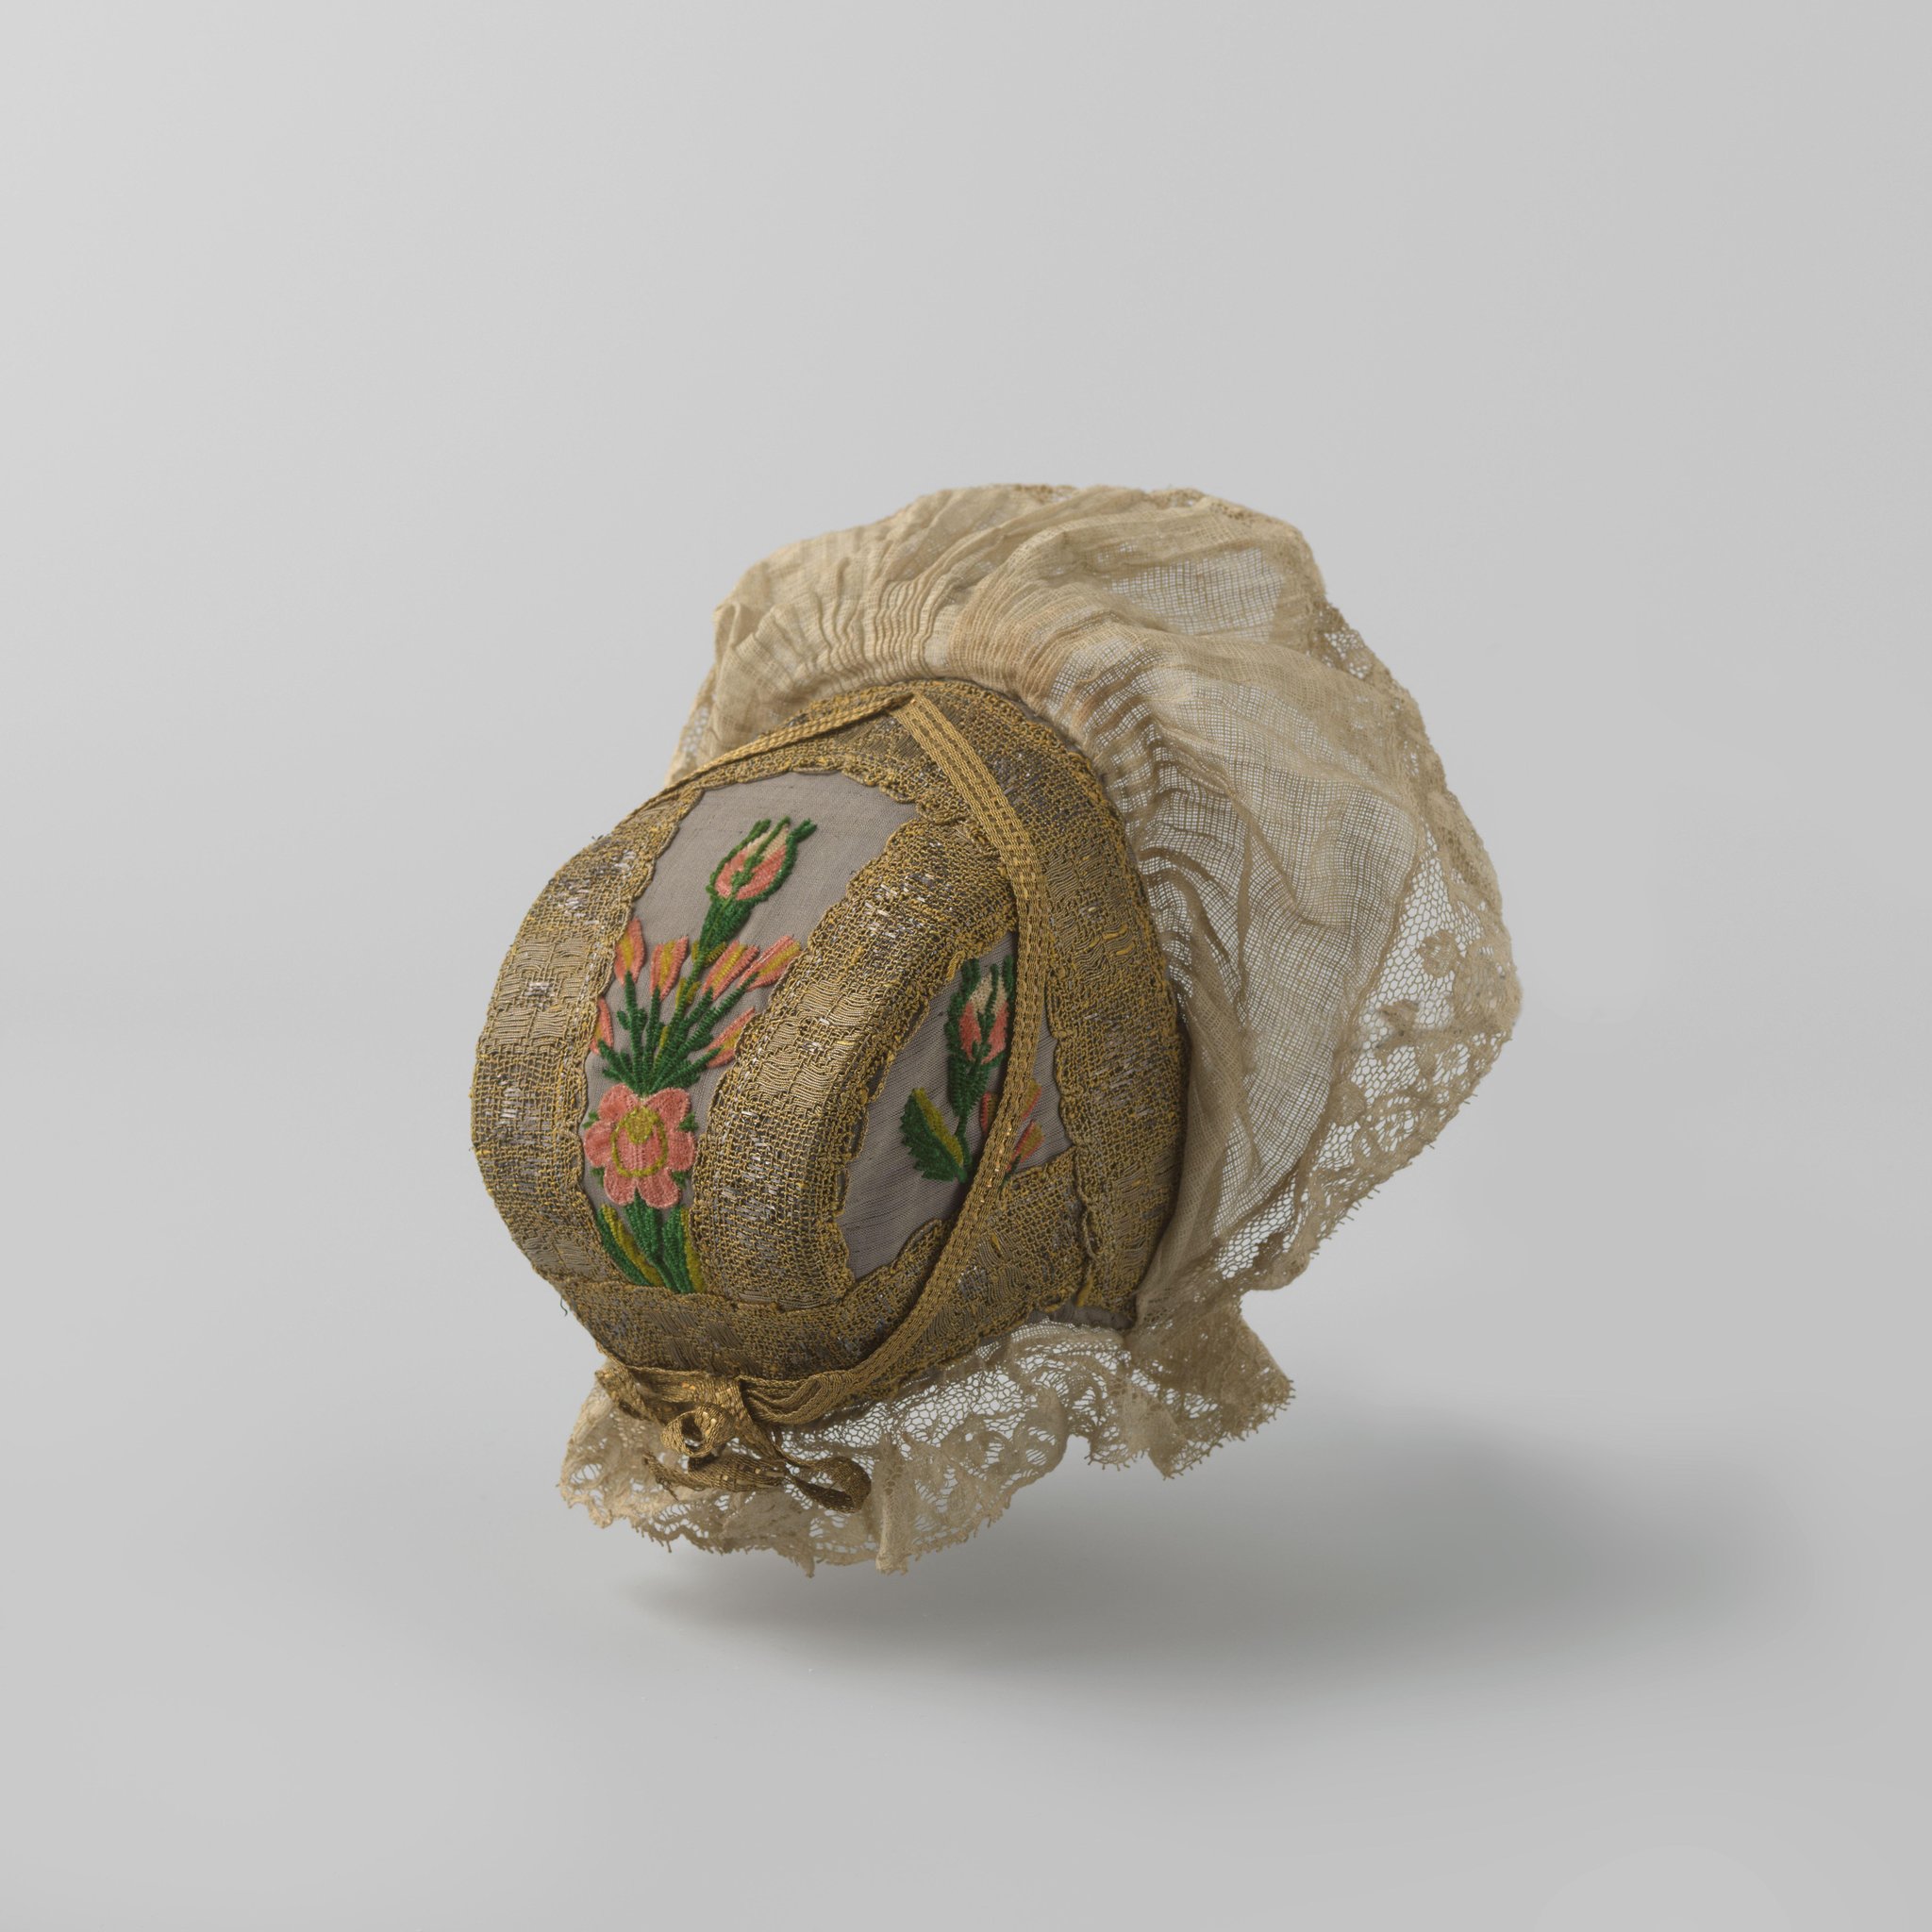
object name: baby wear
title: Babyhoed van lila zijde met toefjes van roze rozen en knop aan tak, voorzien van goudkleurig passement en afgezet met kant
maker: Anonymous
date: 1785-1825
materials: textile, linen, silk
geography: france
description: Babyhoedje van lila zijde versierd met chenille-borduursel en goudpassement, afgezet met kant. Het borduursel bestaat uit een rose roosjes-toefje met knopje aan groene takjes. Machinaal kant. Stijf binnenwerk en voering van grijspaars linnen met wit, geel, bruine strepen.